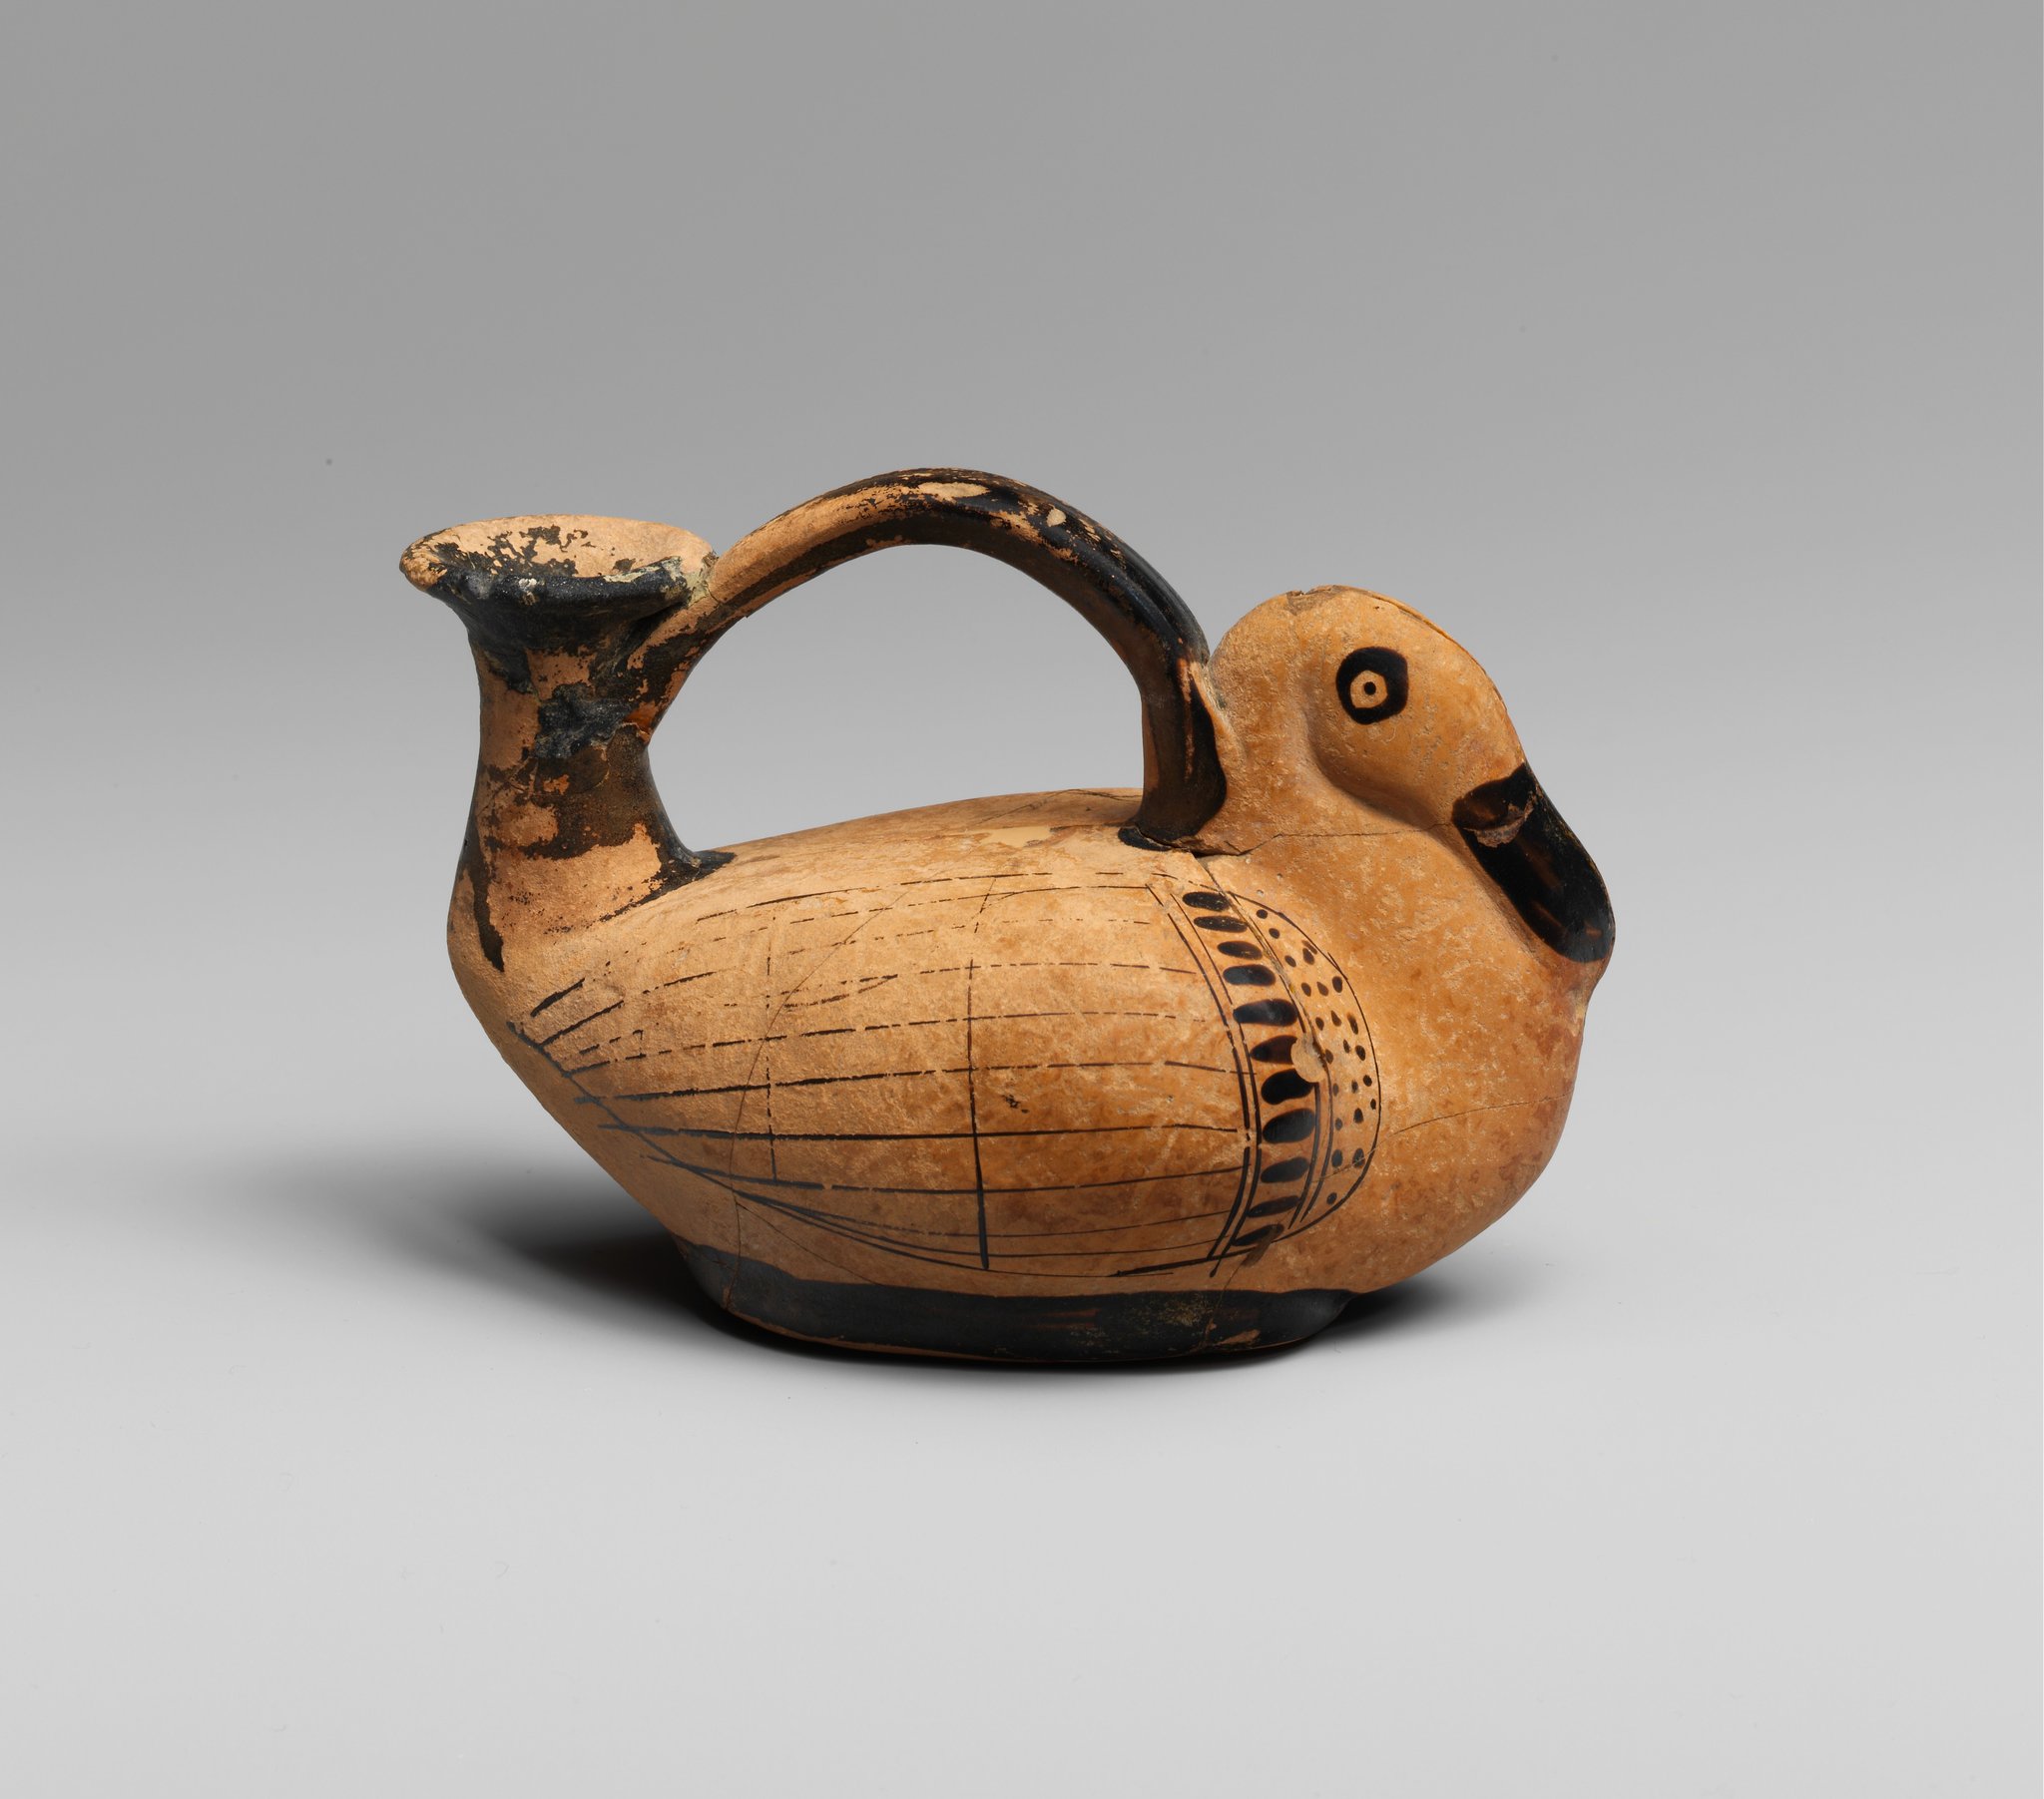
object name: askos in the form of a duck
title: Terracotta askos in the form of a duck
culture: greek, attic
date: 434-401 BCE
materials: terracotta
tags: ducks